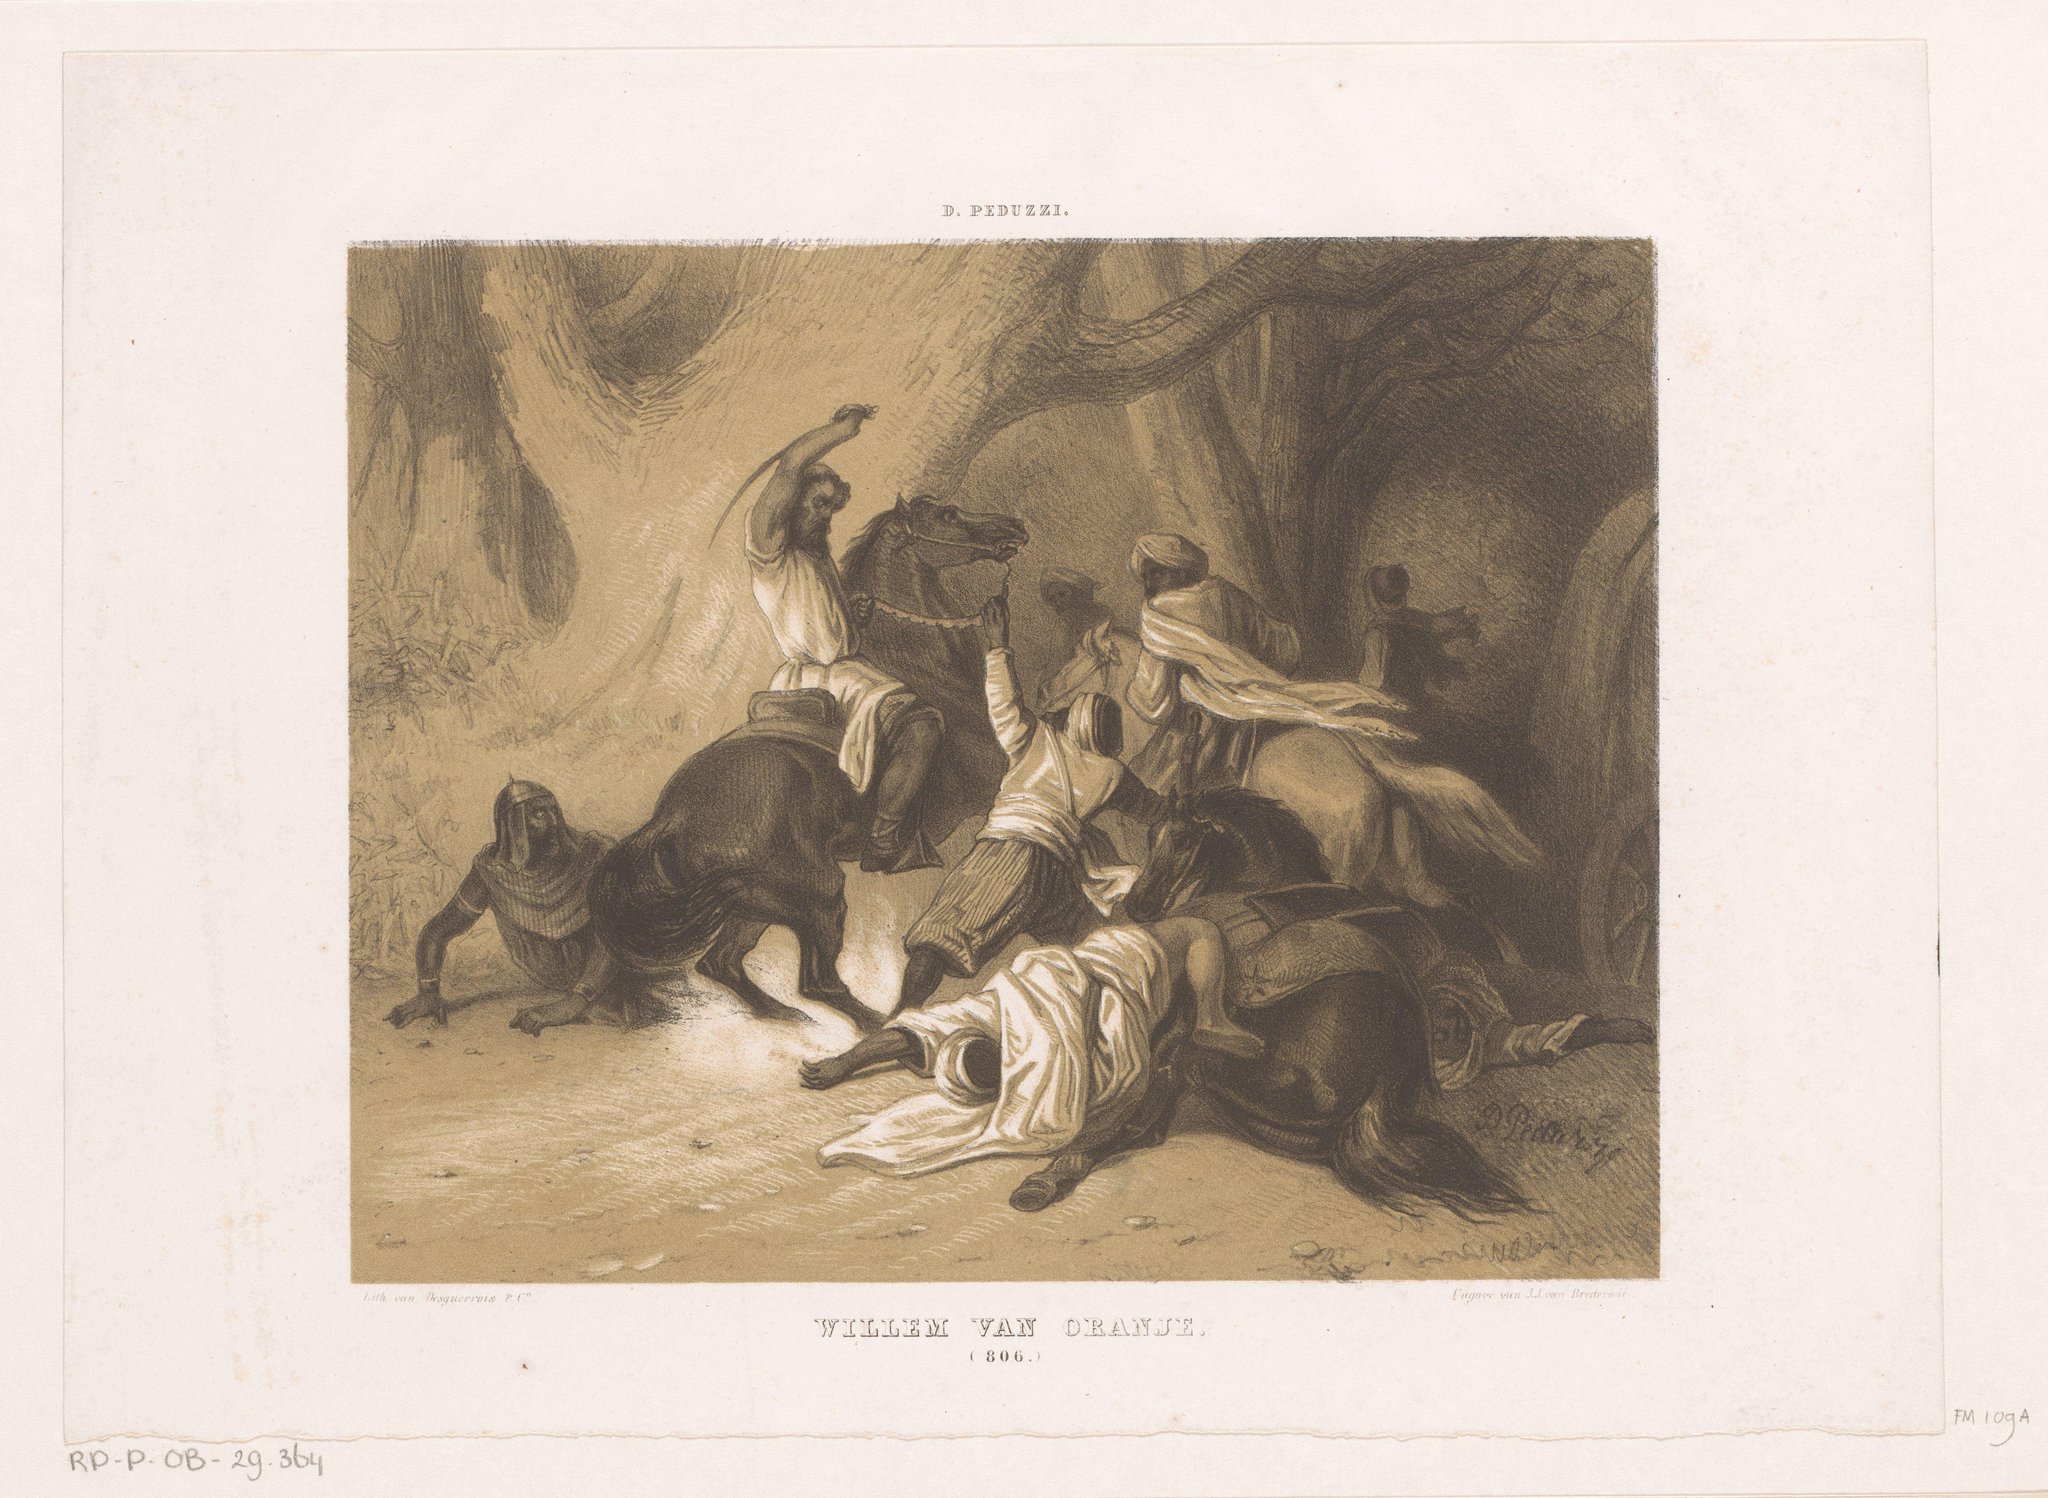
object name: print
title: Willem van Oranje / 806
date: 1849-1861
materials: paper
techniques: tone lithography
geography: amsterdam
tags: battle, freeing a prisoner; ransoming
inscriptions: collector's mark: Lugt 2228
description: Deze episode bezongen in: Guillaume d'Orange, le marquis au court nez : chanson de geste du XIIe siècle, gepubl. door W.J.A. Jonckbloet, Amsterdam 1854.